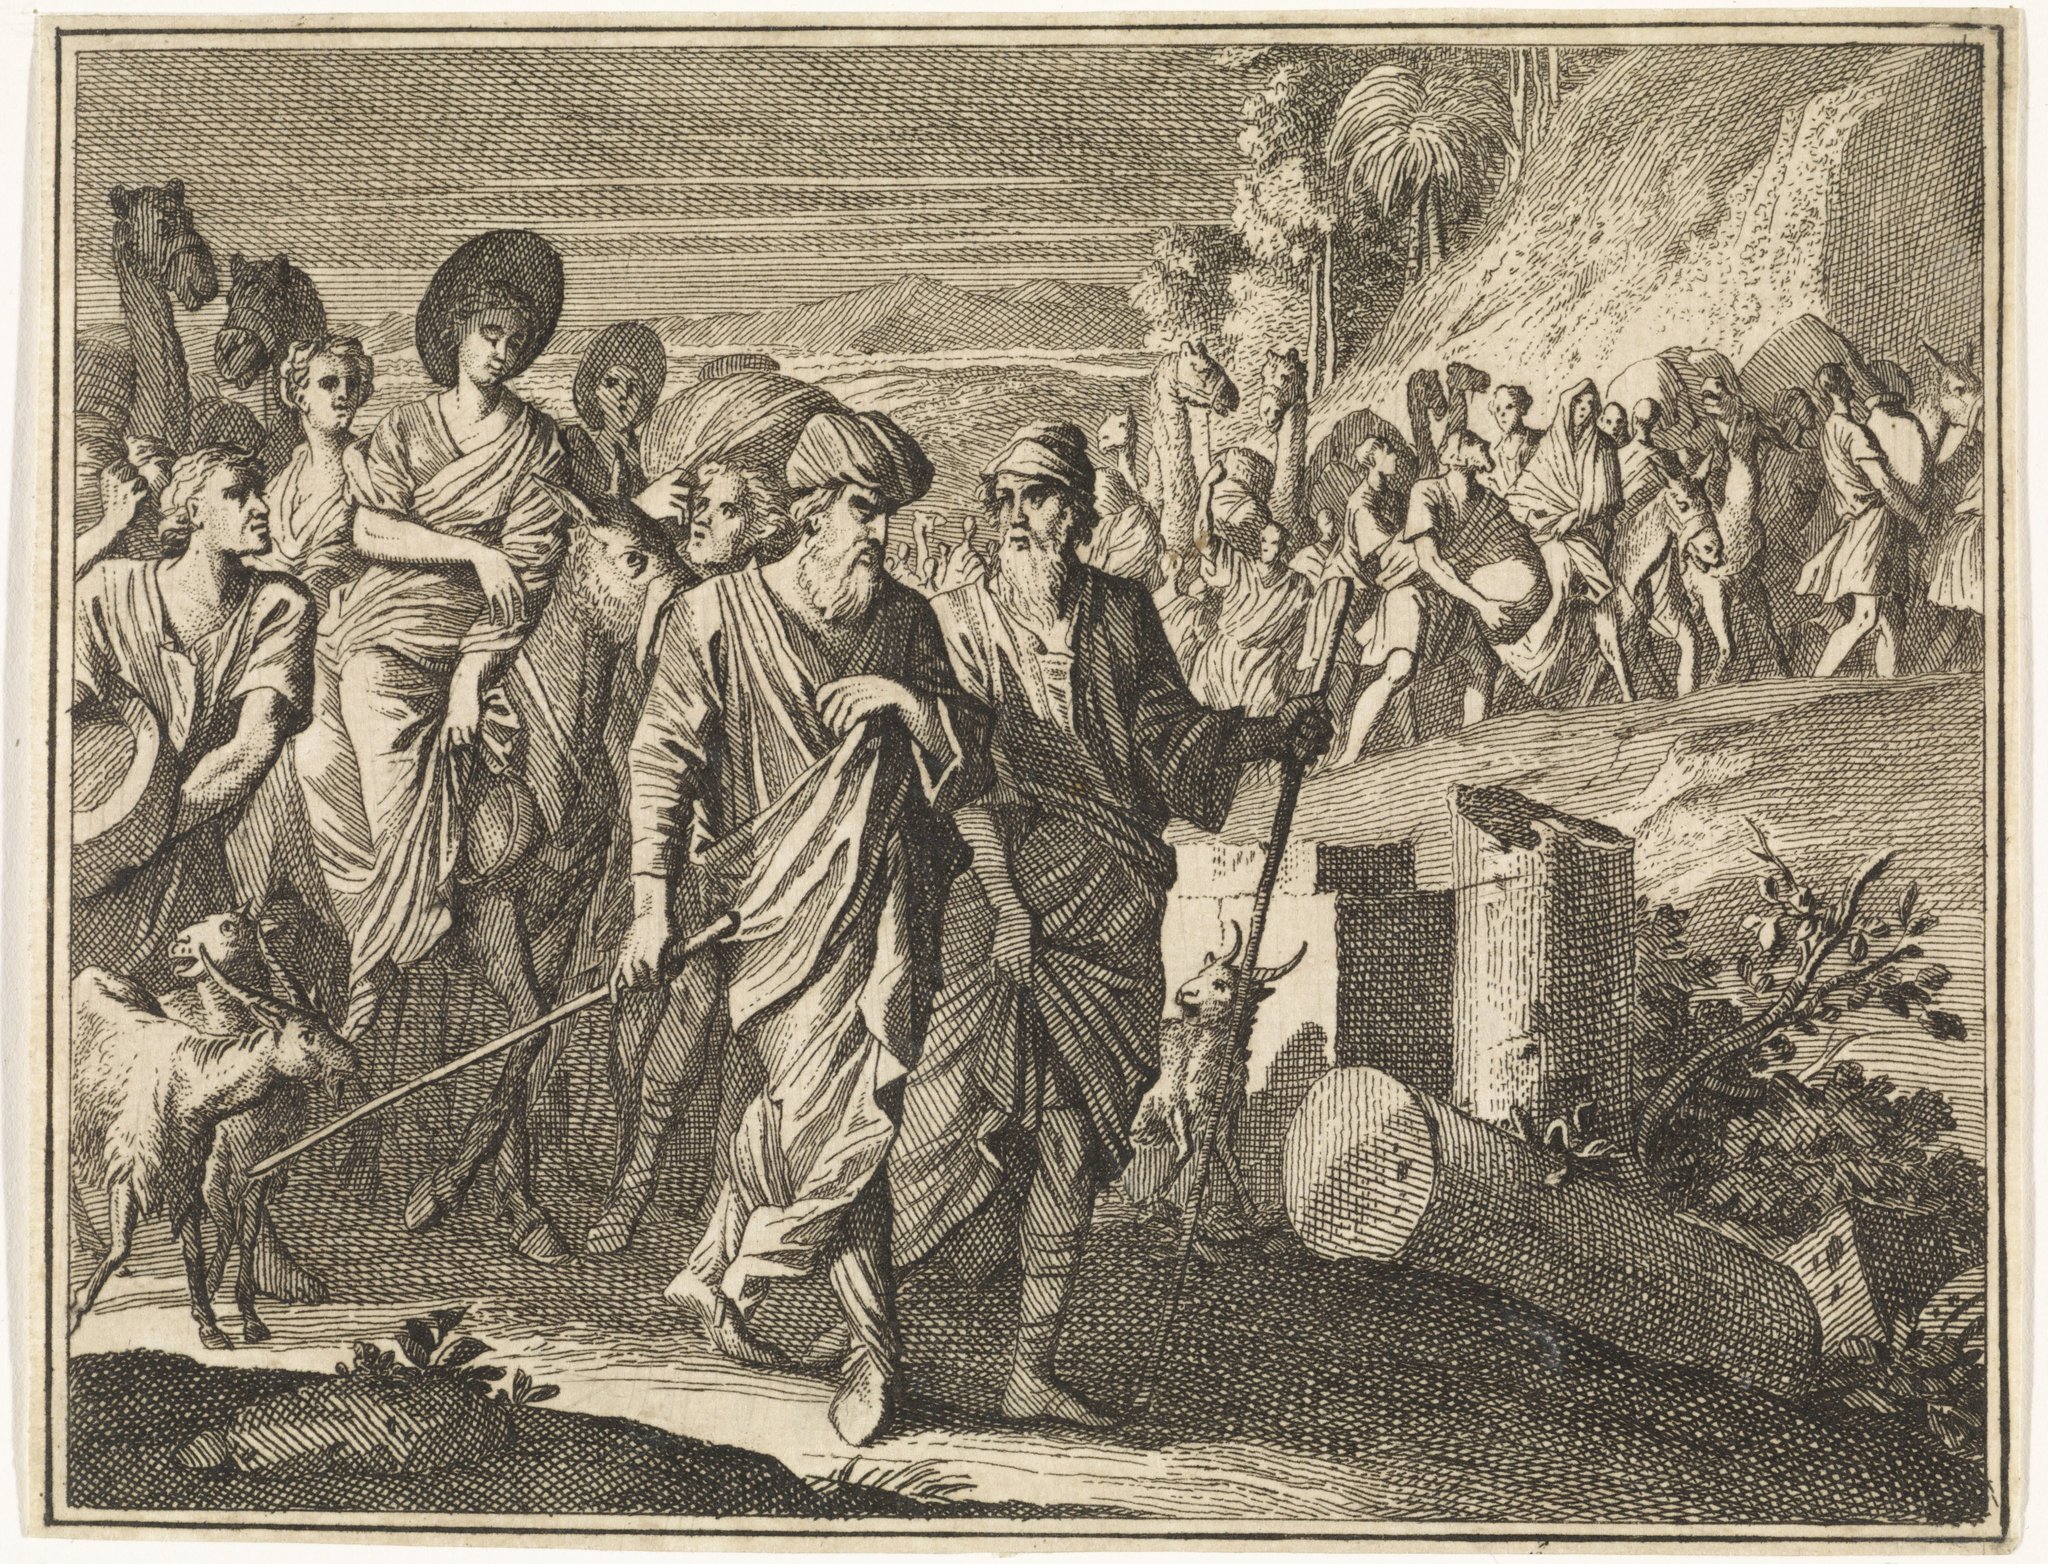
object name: print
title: Abraham en Lot verlaten hun vaderland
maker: caspar luyken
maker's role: draughtsman, print maker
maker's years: 1672-1708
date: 1712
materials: paper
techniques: etching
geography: amsterdam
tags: abraham leaves egypt with sarah, lot, and his possessions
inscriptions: number: ‘17’, collector's mark: Lugt 2228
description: Illustratie uit: Luyken, Jan. De schriftuurlyke geschiedenissen en gelykenissen van het Oude en Nieuwe Verbond, 2 delen. Amsterdam: Wed. Pieter Arentsz II en Cornelis van der Sys, 1712, dl. I.